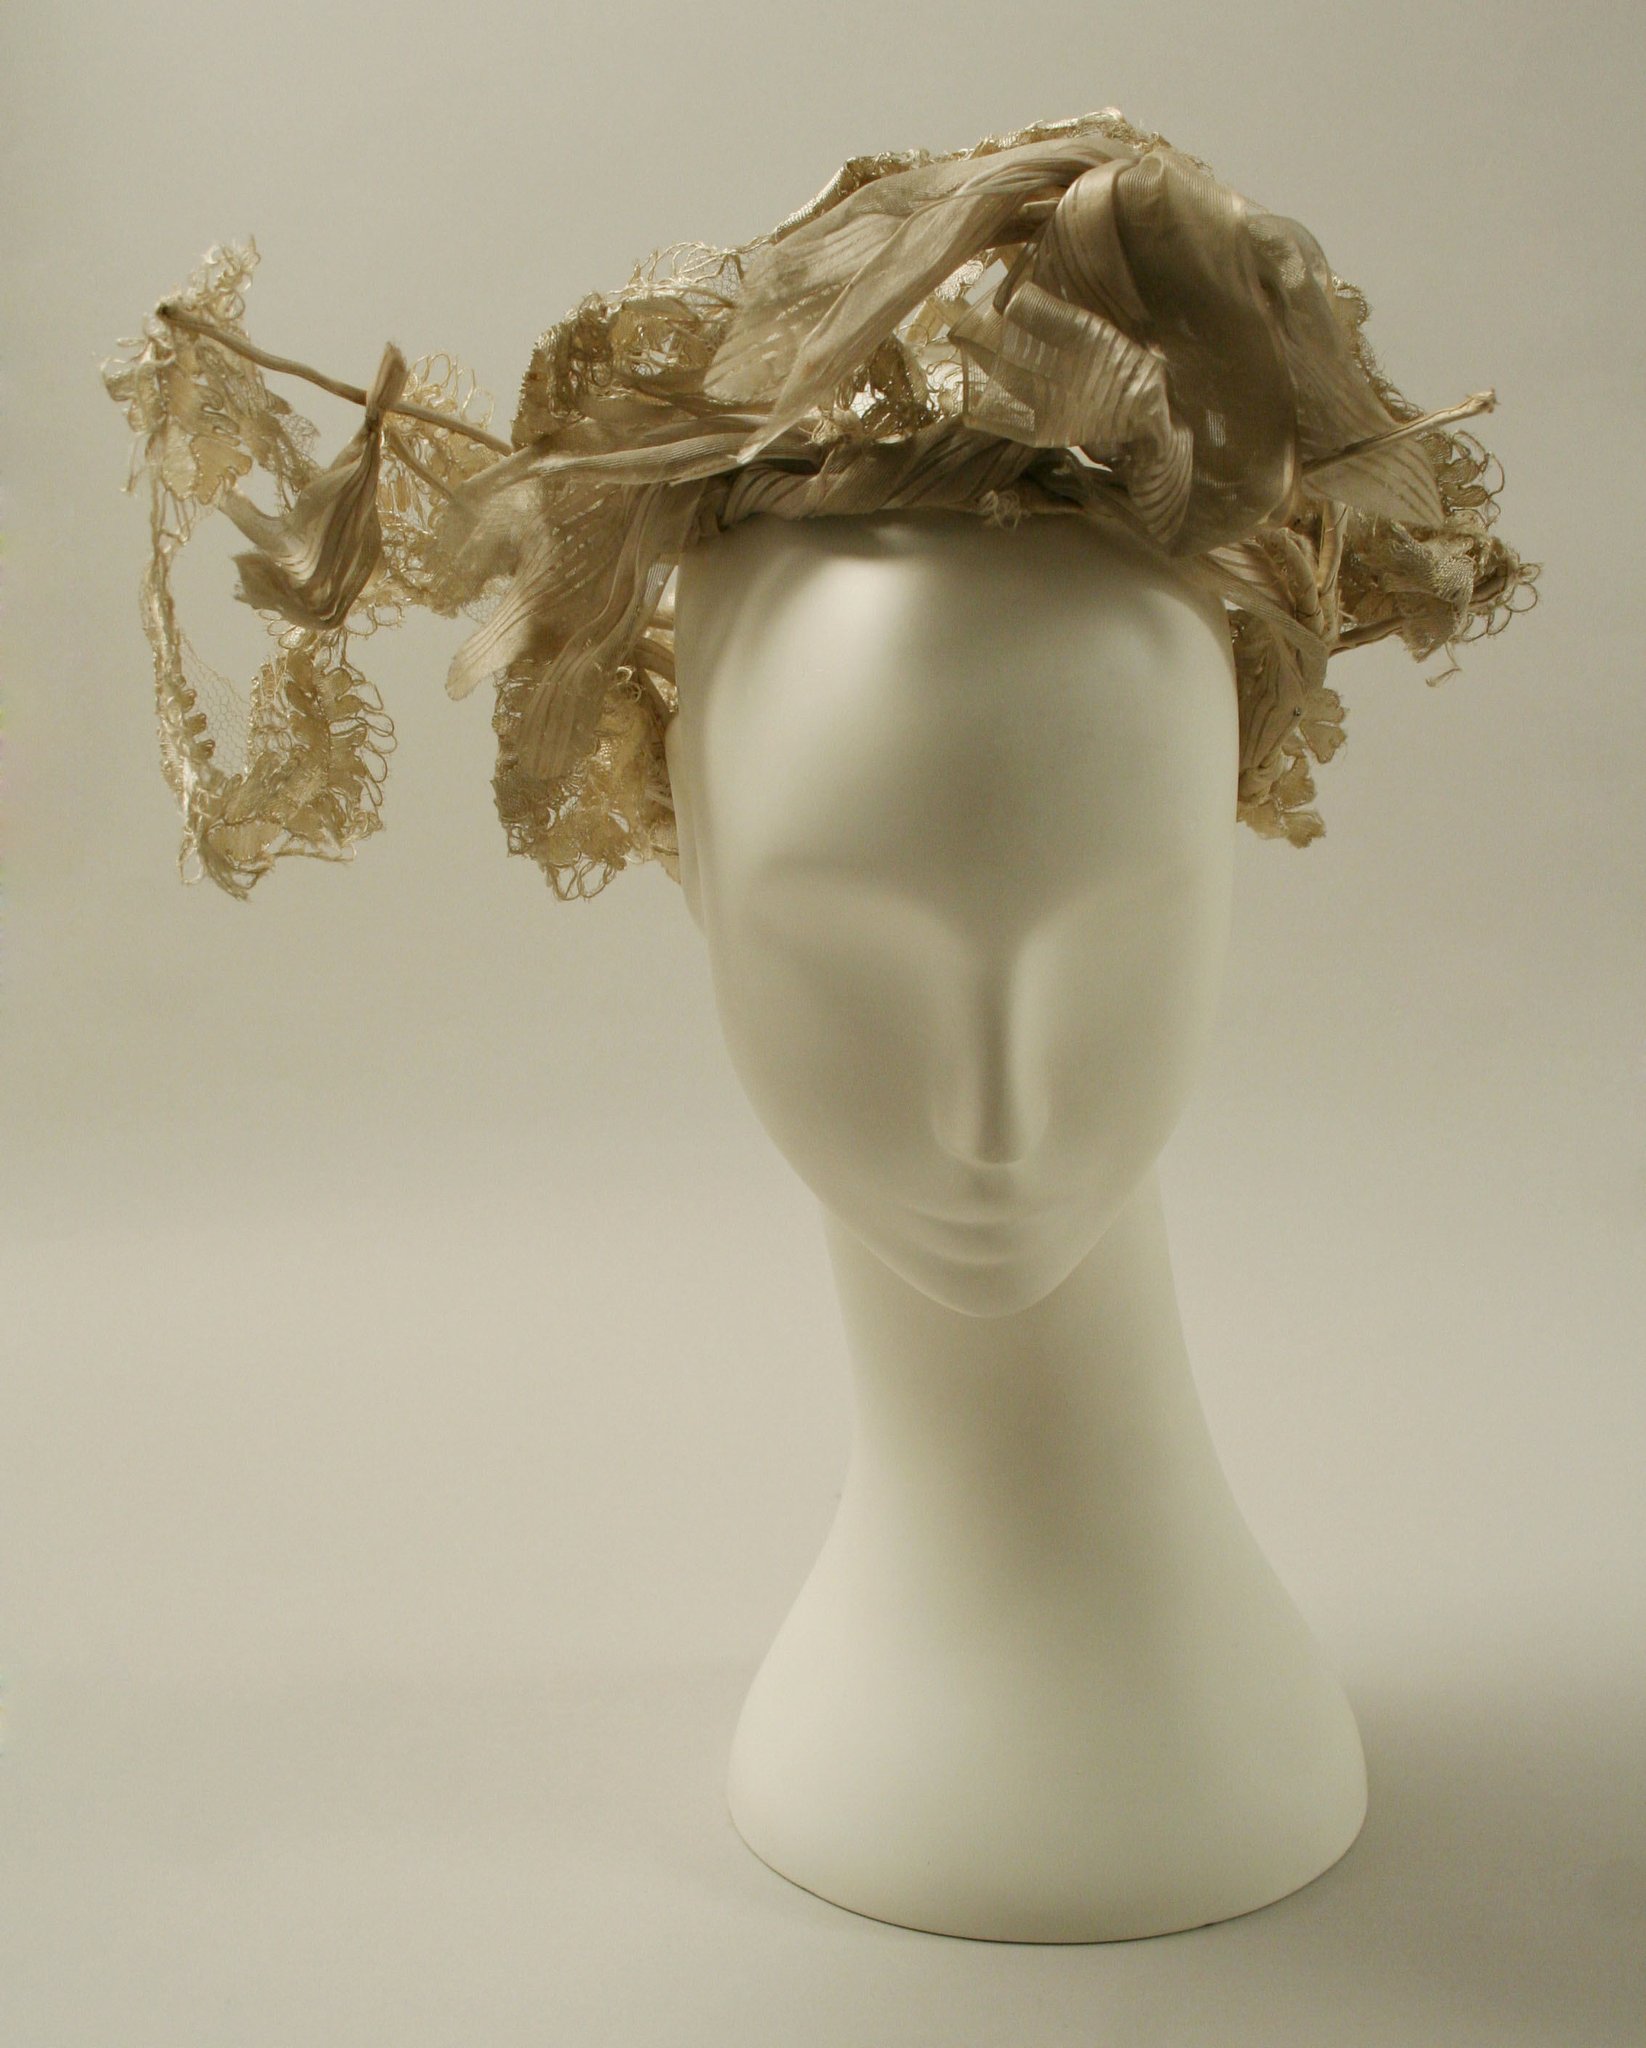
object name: hat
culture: french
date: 1830-1839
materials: silk